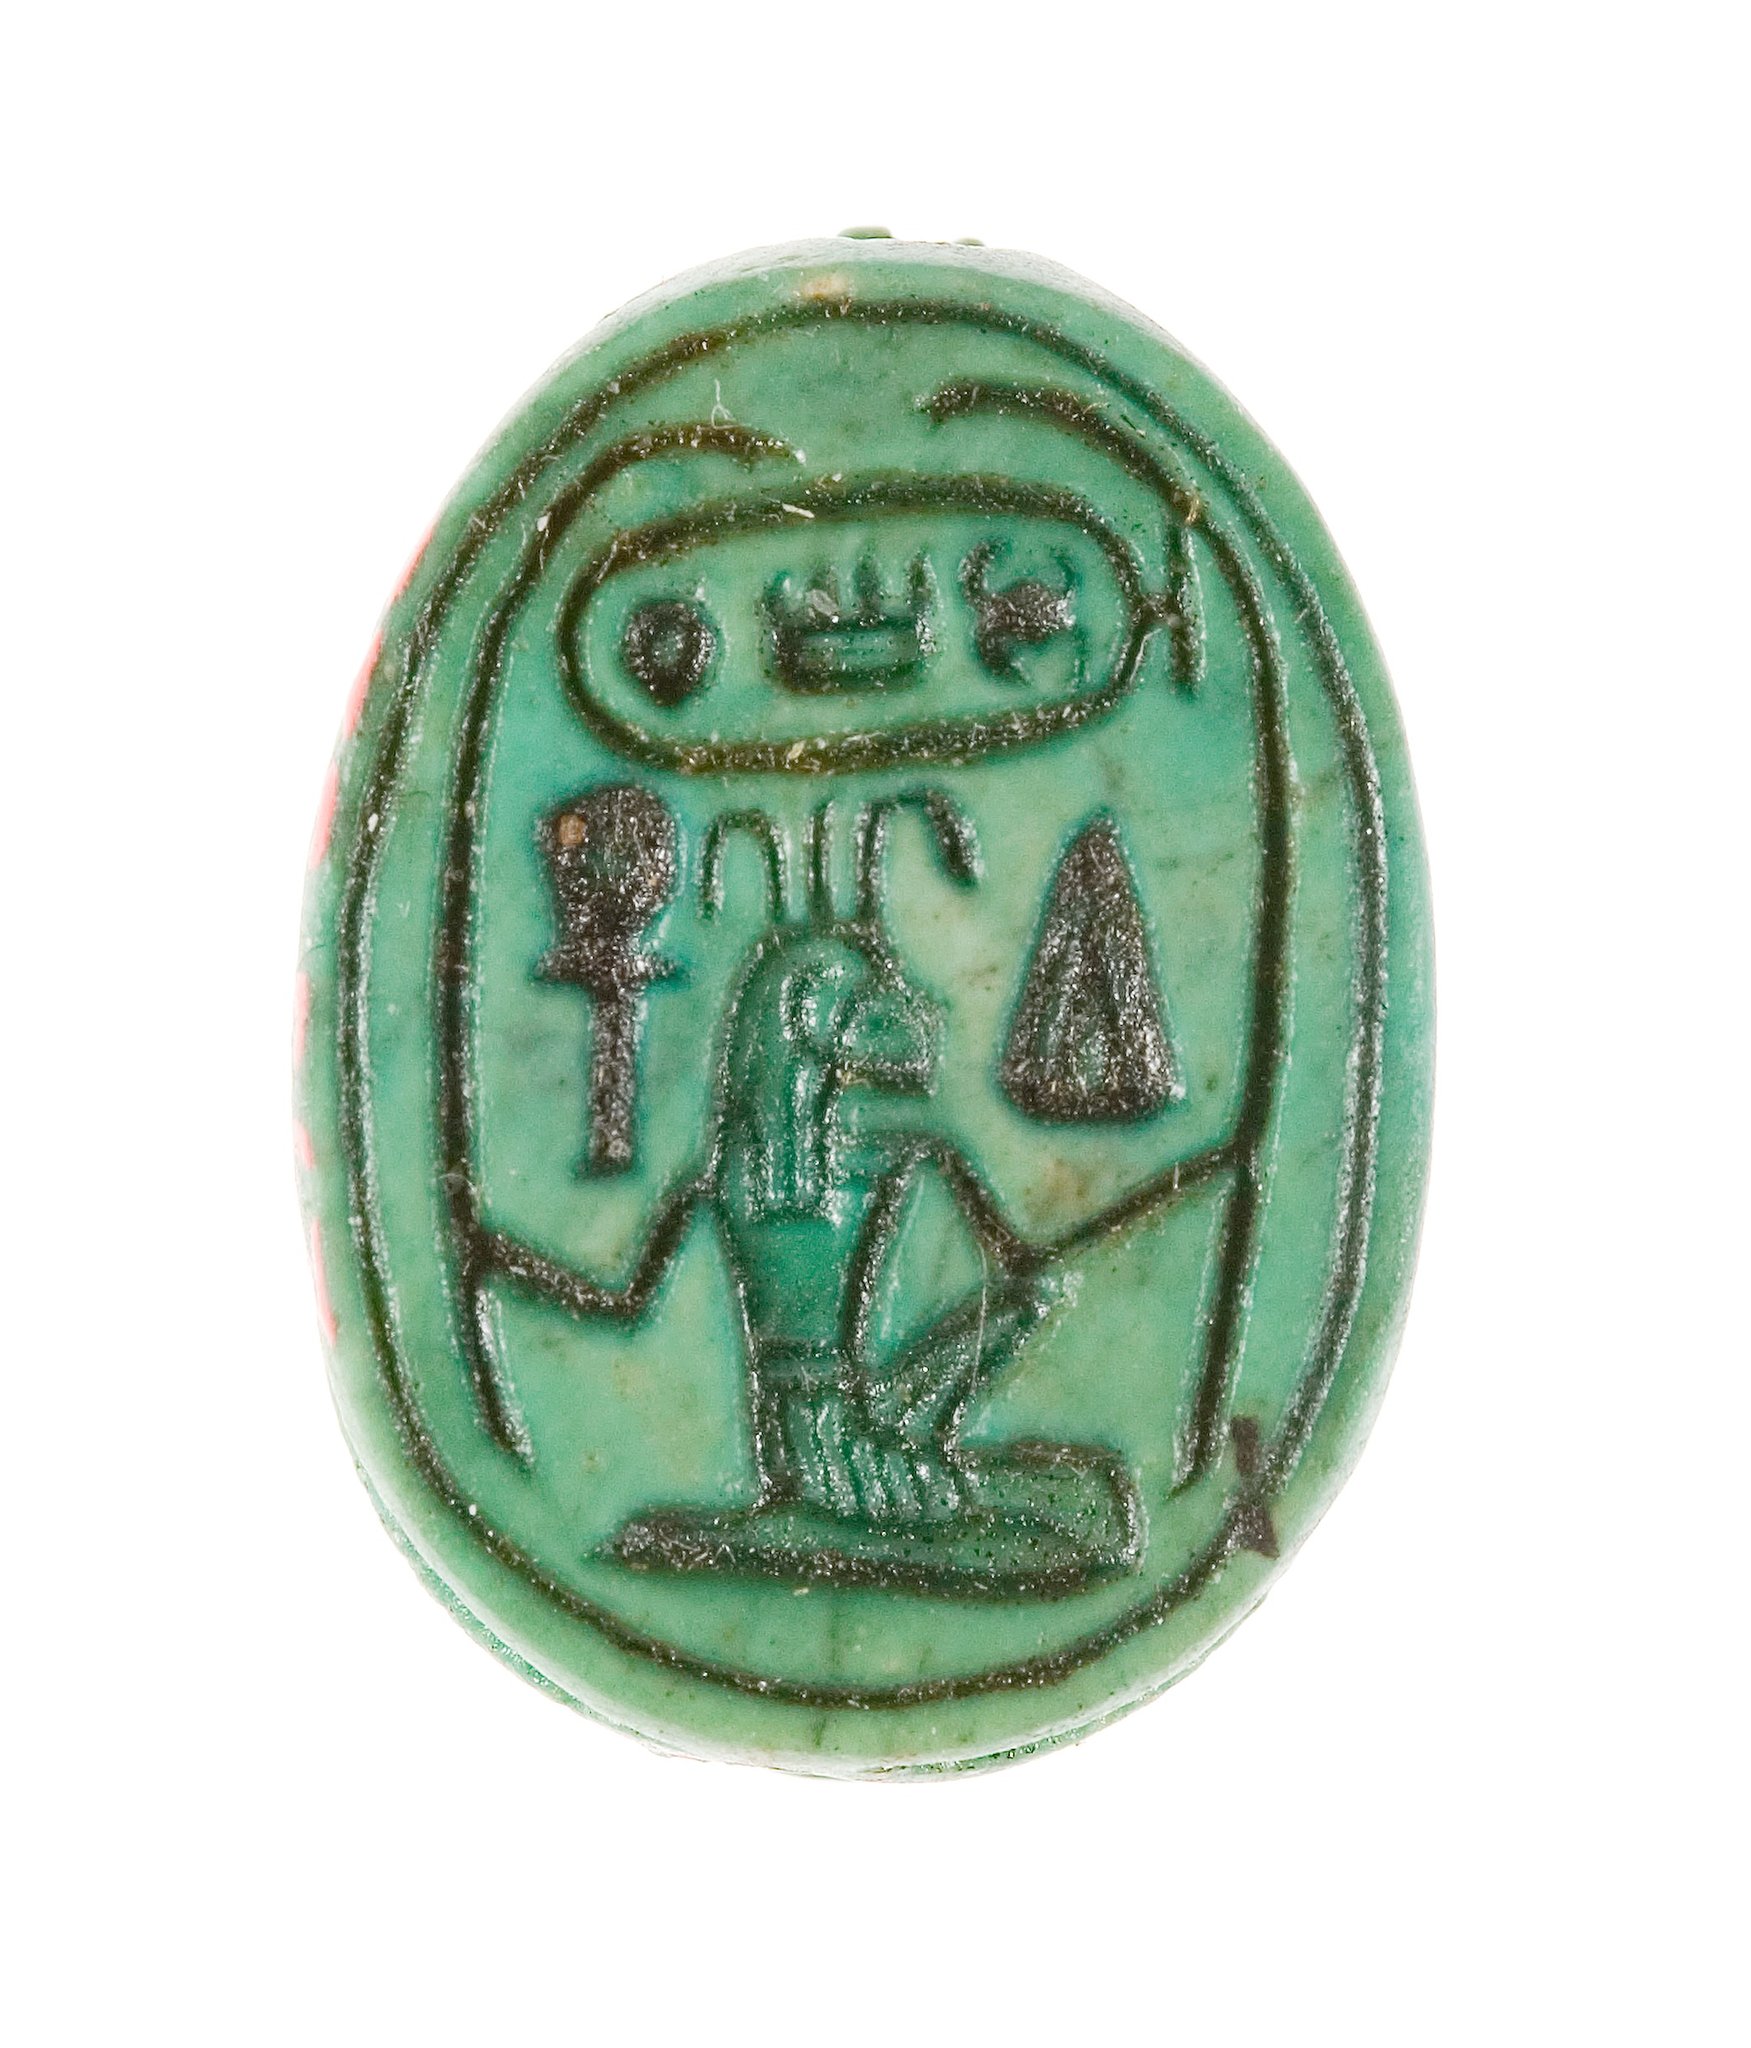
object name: scarab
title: Scarab Inscribed with the Throne Name of Thutmose III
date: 1479-1458 BCE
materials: stone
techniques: glazing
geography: egypt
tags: hieroglyphs,scarabs